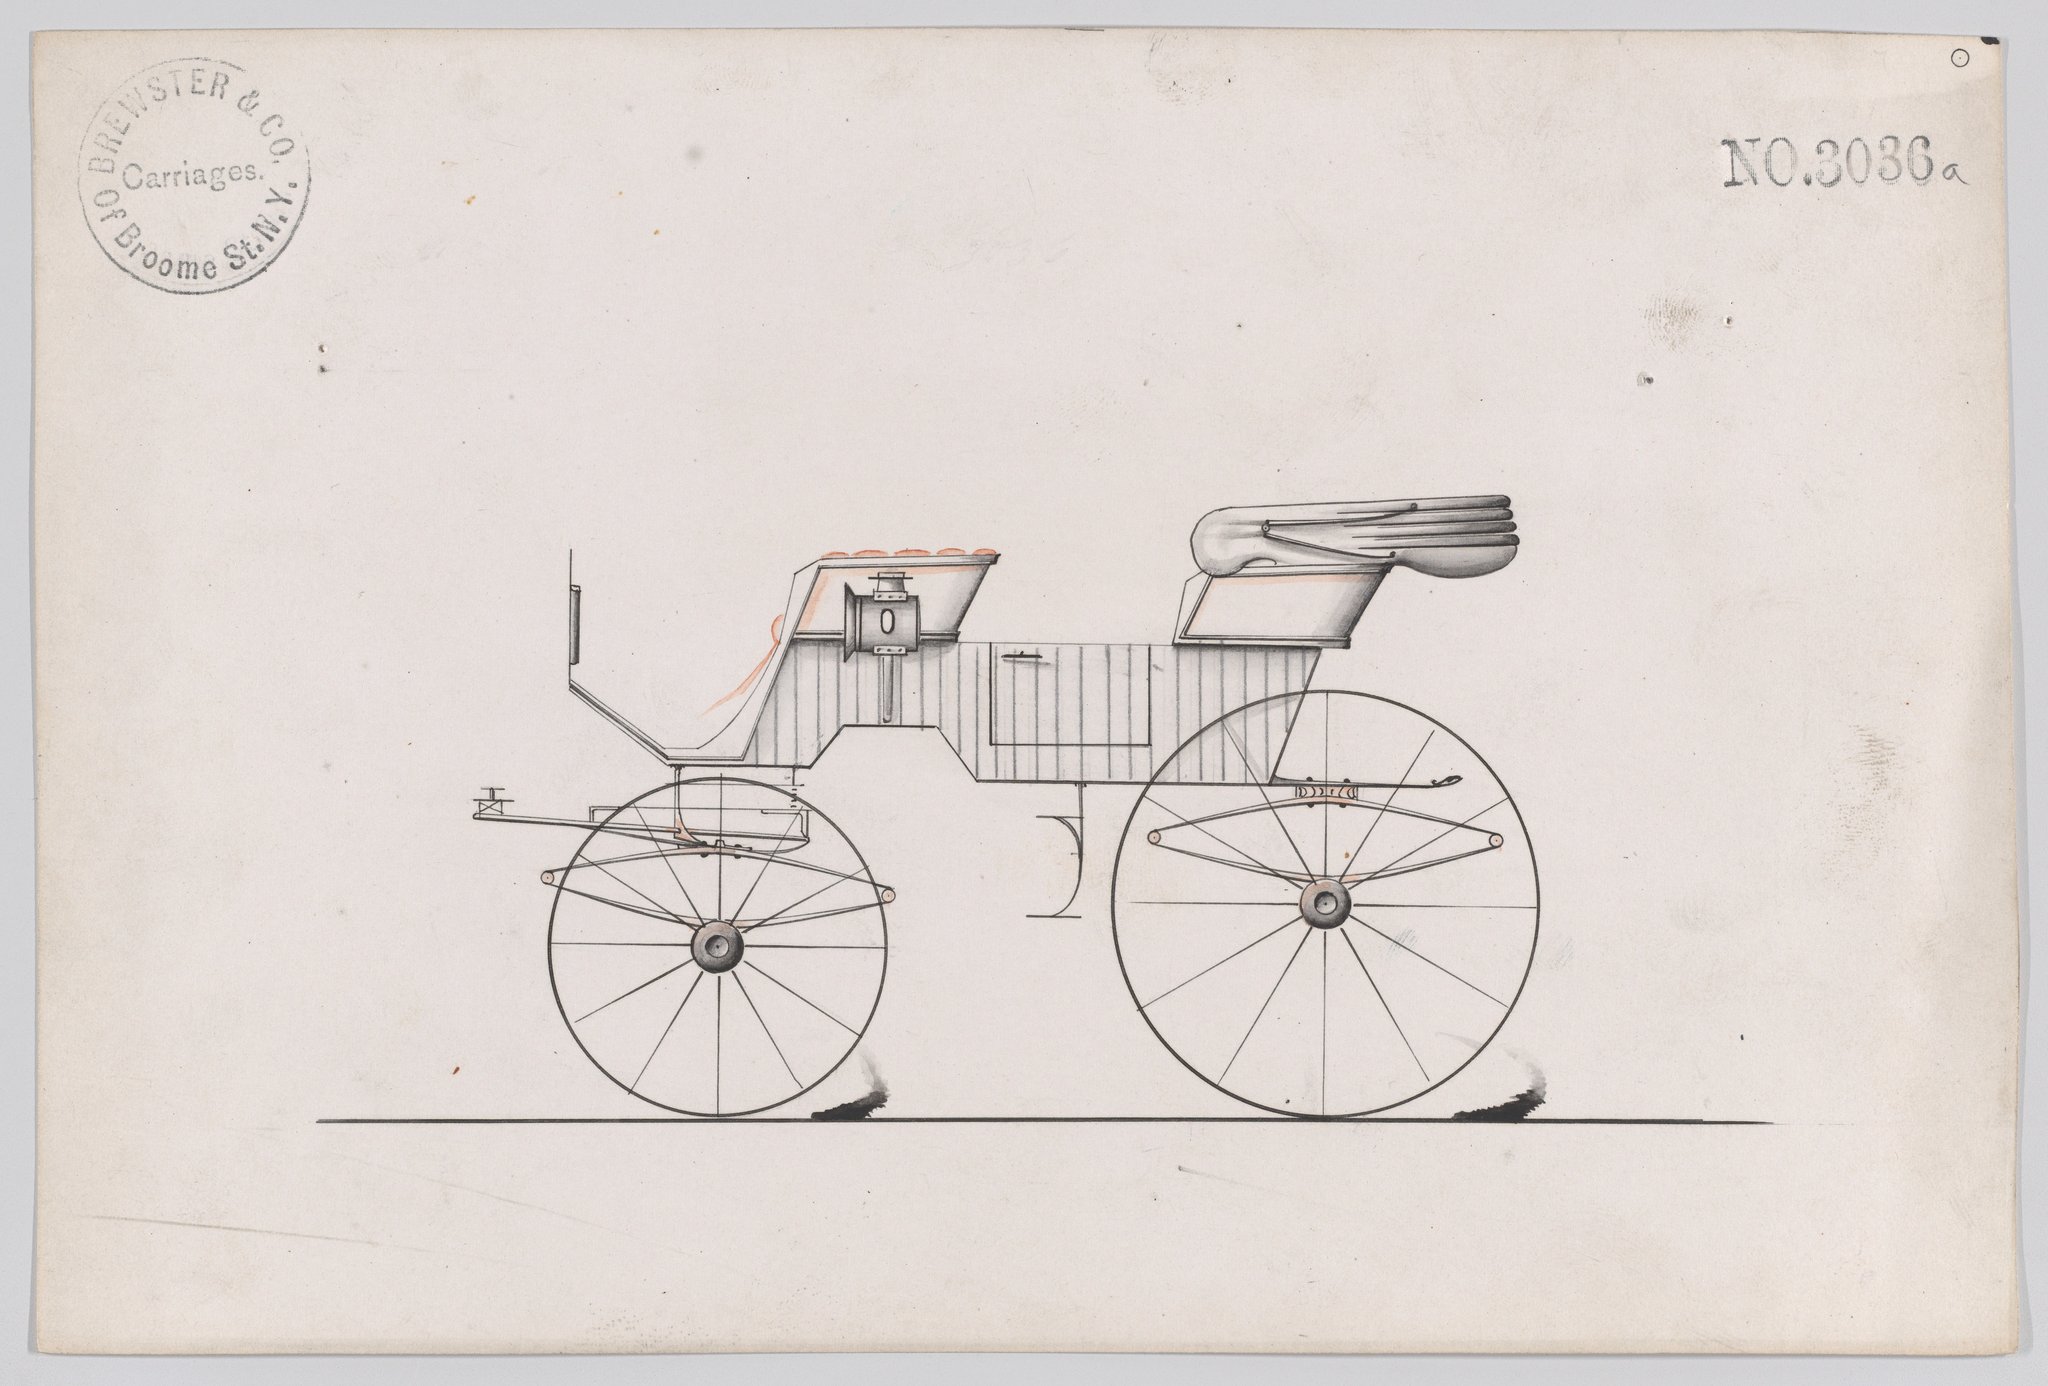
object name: drawing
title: Design for 2 seat Phaeton, no. 3036a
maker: brewster & co.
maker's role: manufacturer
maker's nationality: american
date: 1874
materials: ink, watercolor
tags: carriages